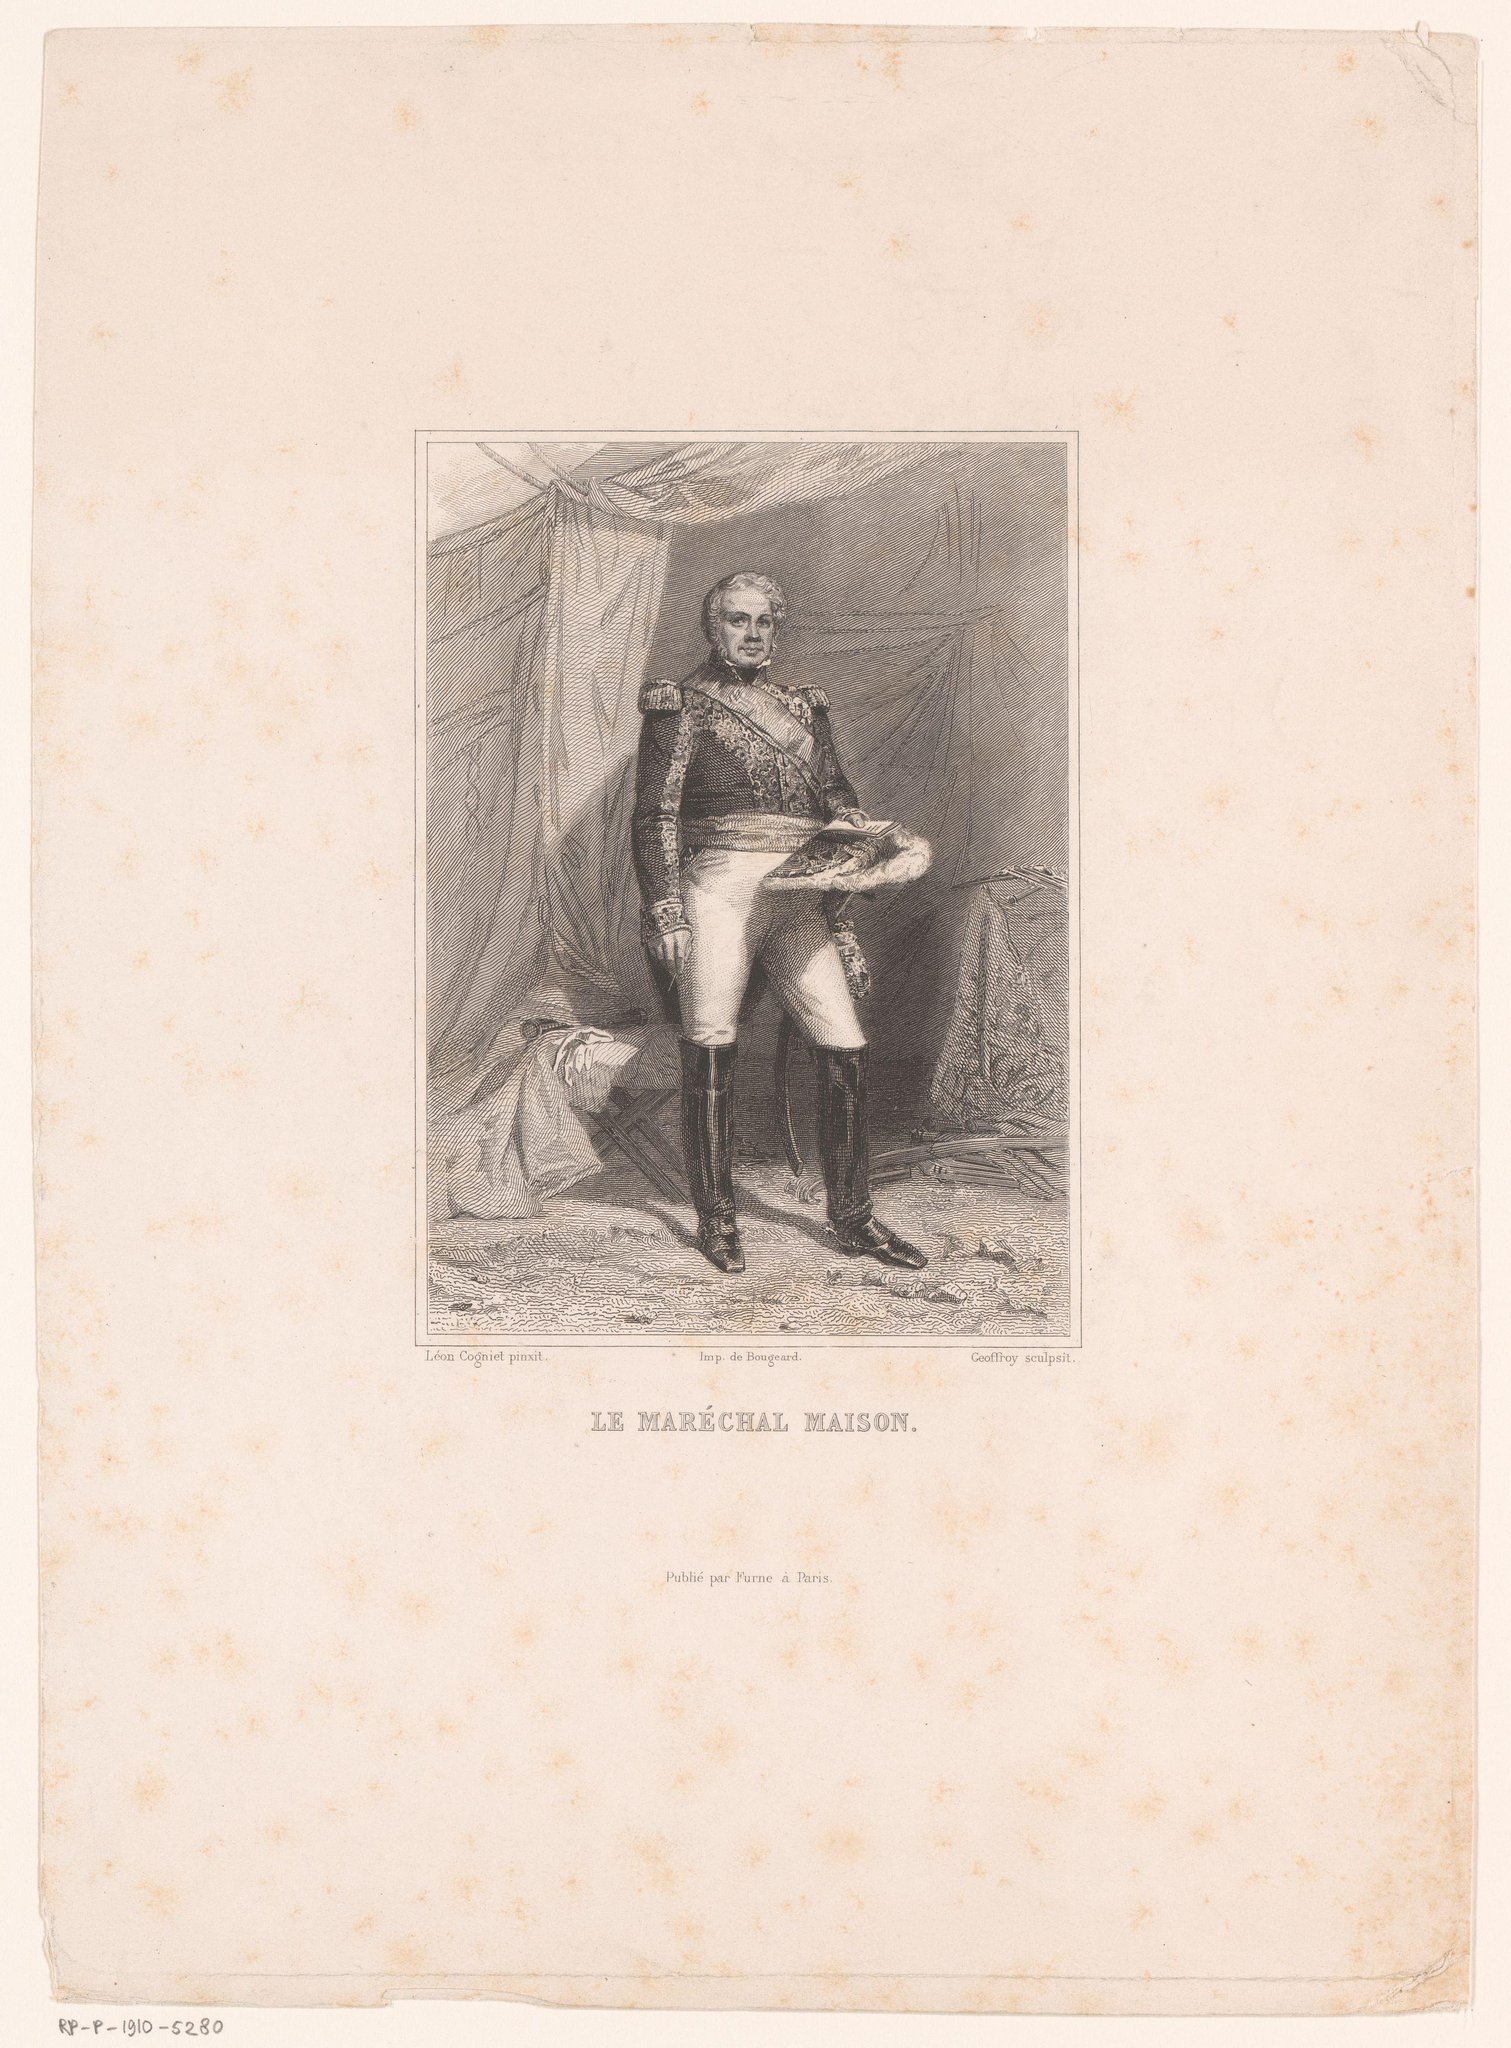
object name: print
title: Portret van Nicolas Joseph Maison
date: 1829-1849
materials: paper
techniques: engraving, etching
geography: paris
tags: paris, commander-in-chief, general, marshal, historical persons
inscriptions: collector's mark: Lugt 2228